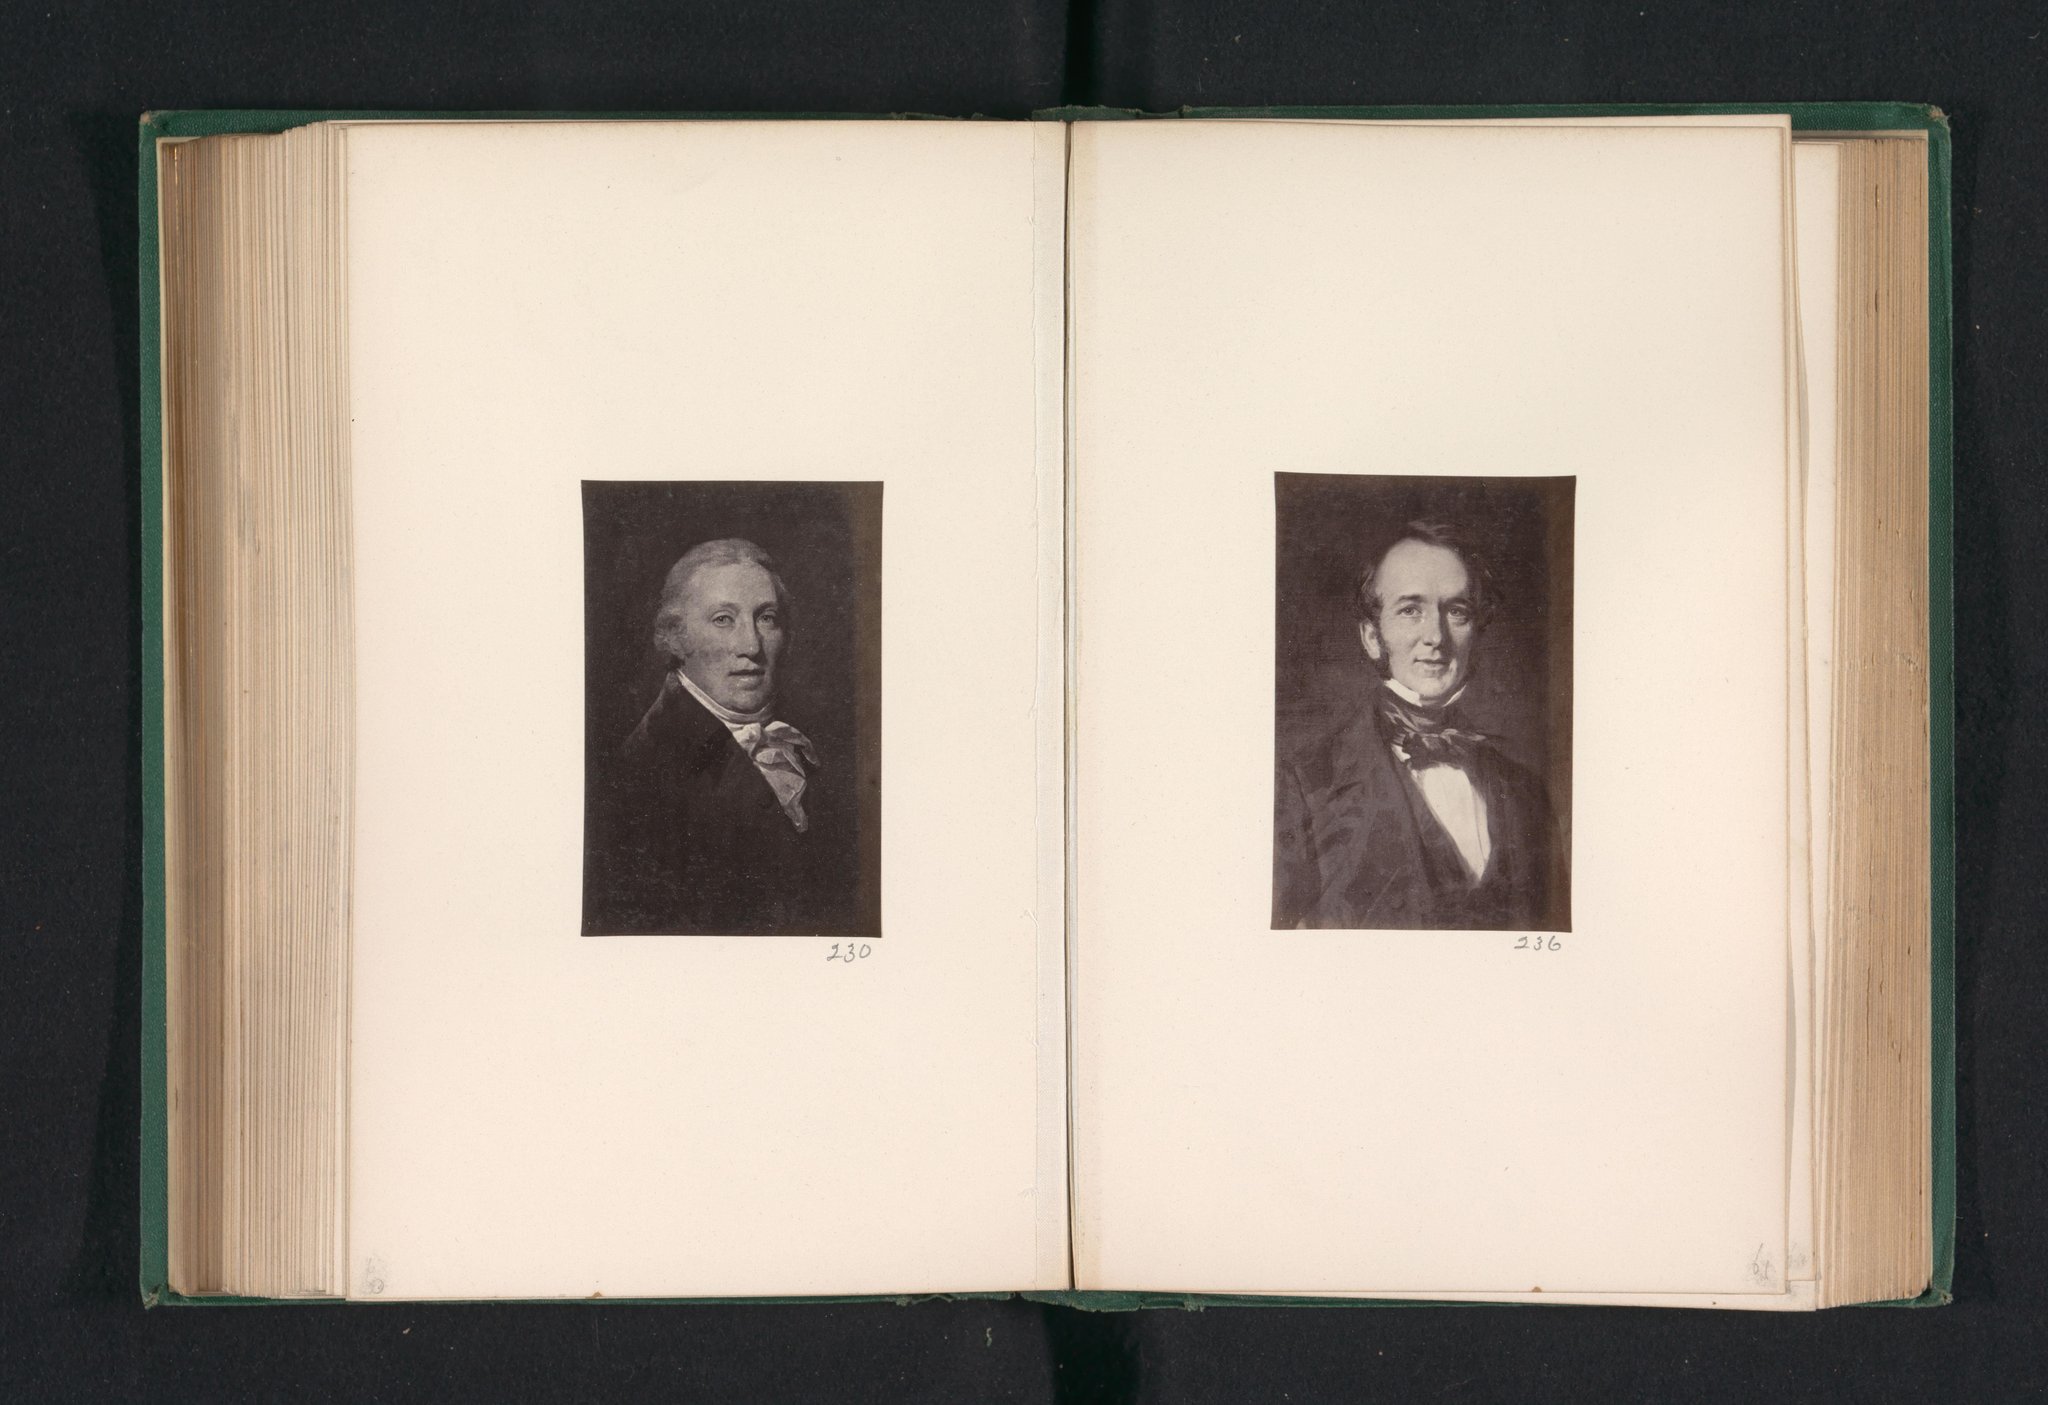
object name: photograph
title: Fotoreproductie van een schilderij, voorstellende een portret van John Dunlop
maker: thomas annan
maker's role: fotograaf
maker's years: 1829-1887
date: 1863-1868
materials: photographic support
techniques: albumen print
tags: historical persons (portraits and scenes from the life) (+ (full) bust portrait)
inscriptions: number: ‘230’